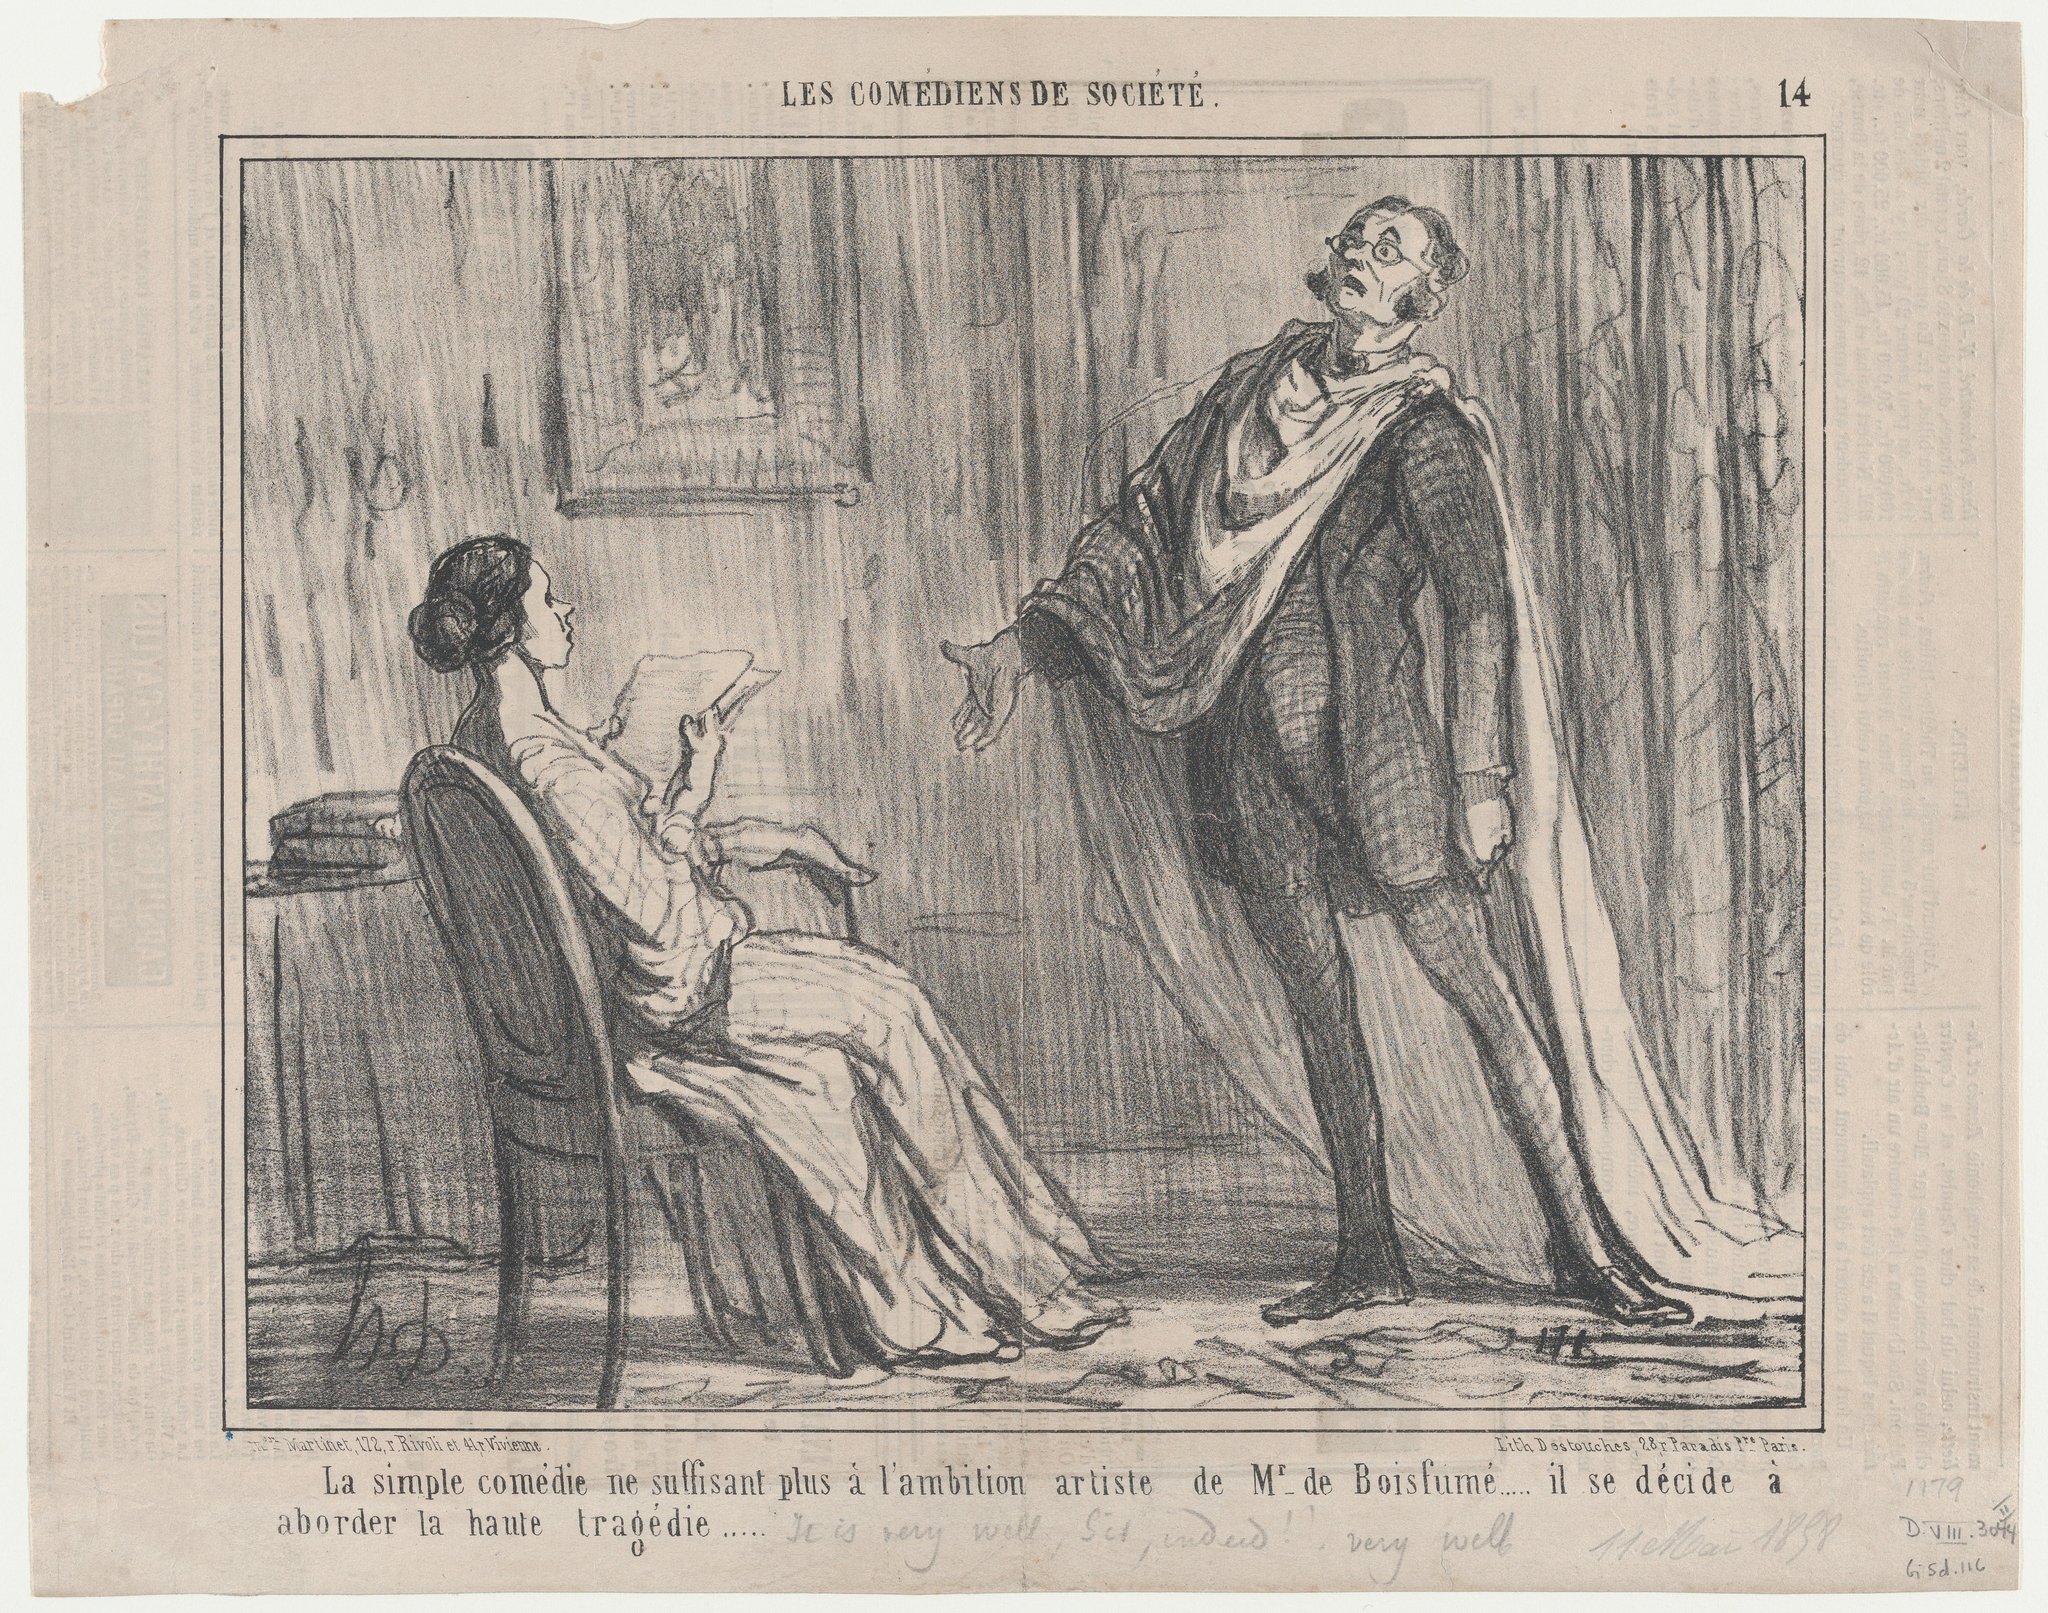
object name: print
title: La simple comédie ne suffisant plus à l'ambition artiste de Mr. de Boisfumé..., from Les Comédiens de Société, published in Le Charivari, May 11, 1858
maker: honoré daumier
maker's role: artist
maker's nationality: french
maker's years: 1808-1879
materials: paper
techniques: lithograph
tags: satire,men,women